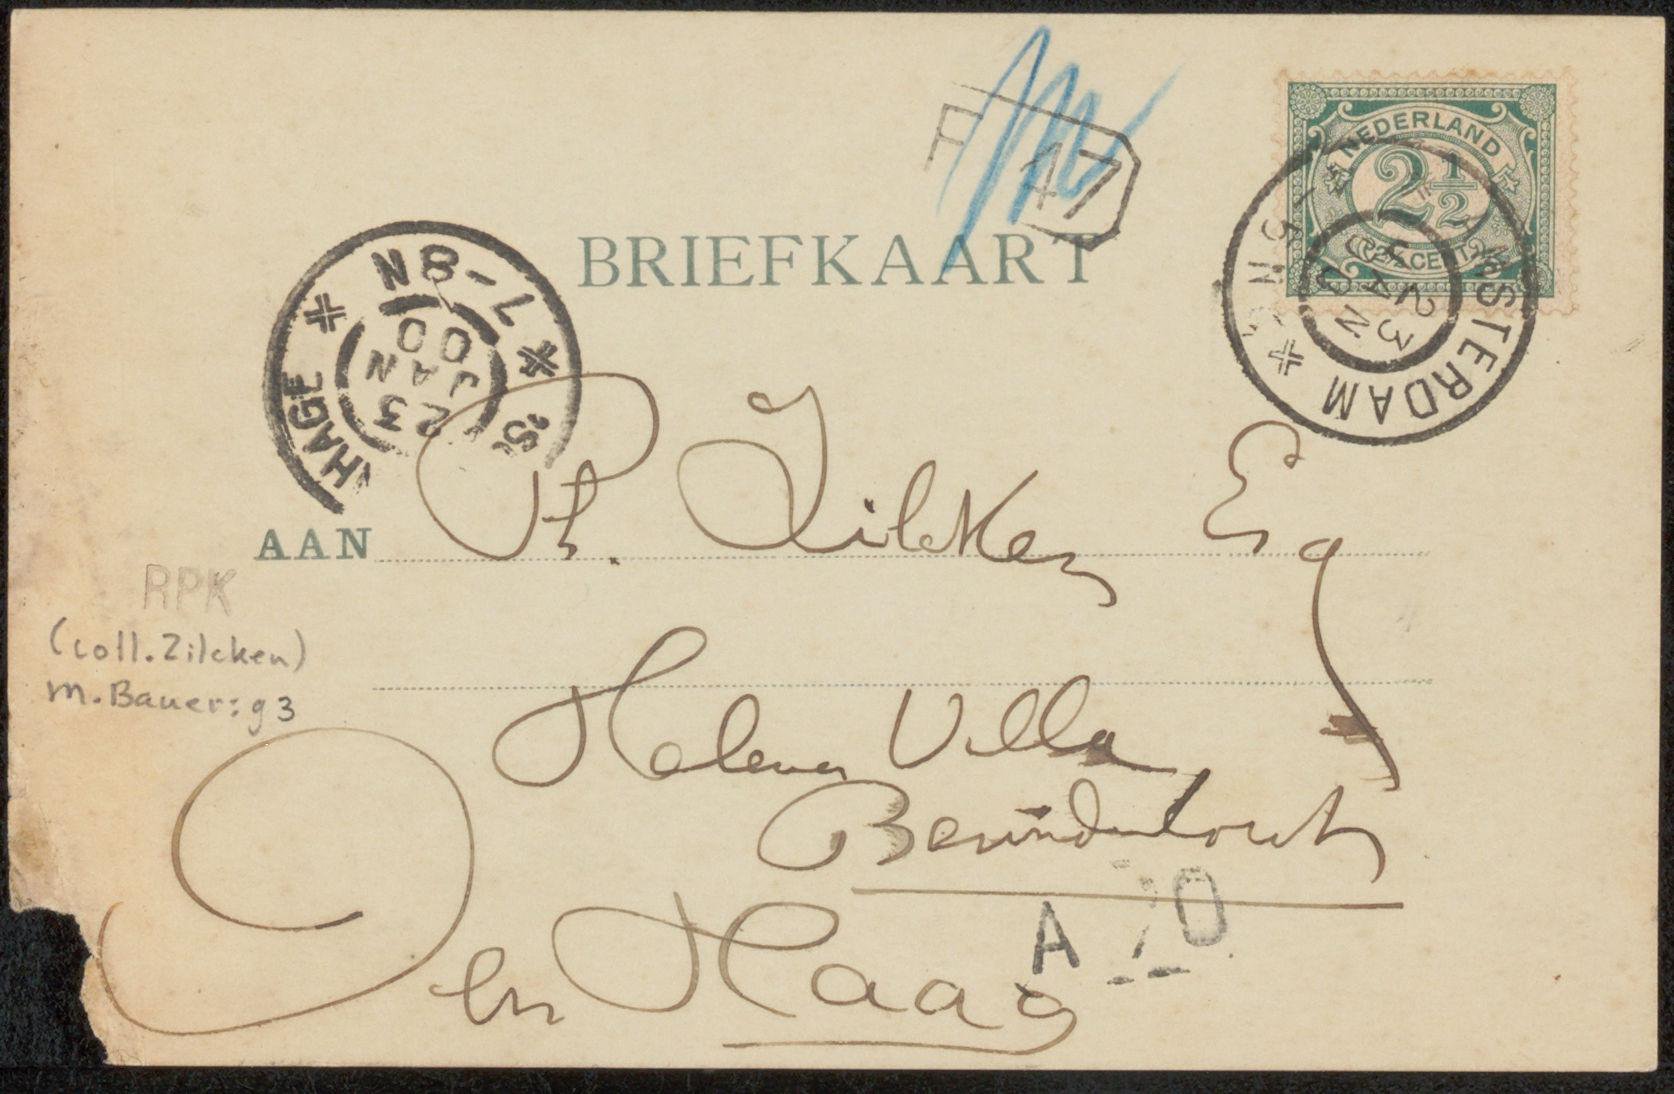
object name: postcard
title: Briefkaart aan Philip Zilcken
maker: marius bauer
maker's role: draughtsman, print maker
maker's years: 1867-1932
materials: cardboard, ink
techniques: pen, writing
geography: amsterdam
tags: painter, marinus van der maarel, etienne bosch, philip zilcken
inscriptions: collector's mark: ‘RPK’